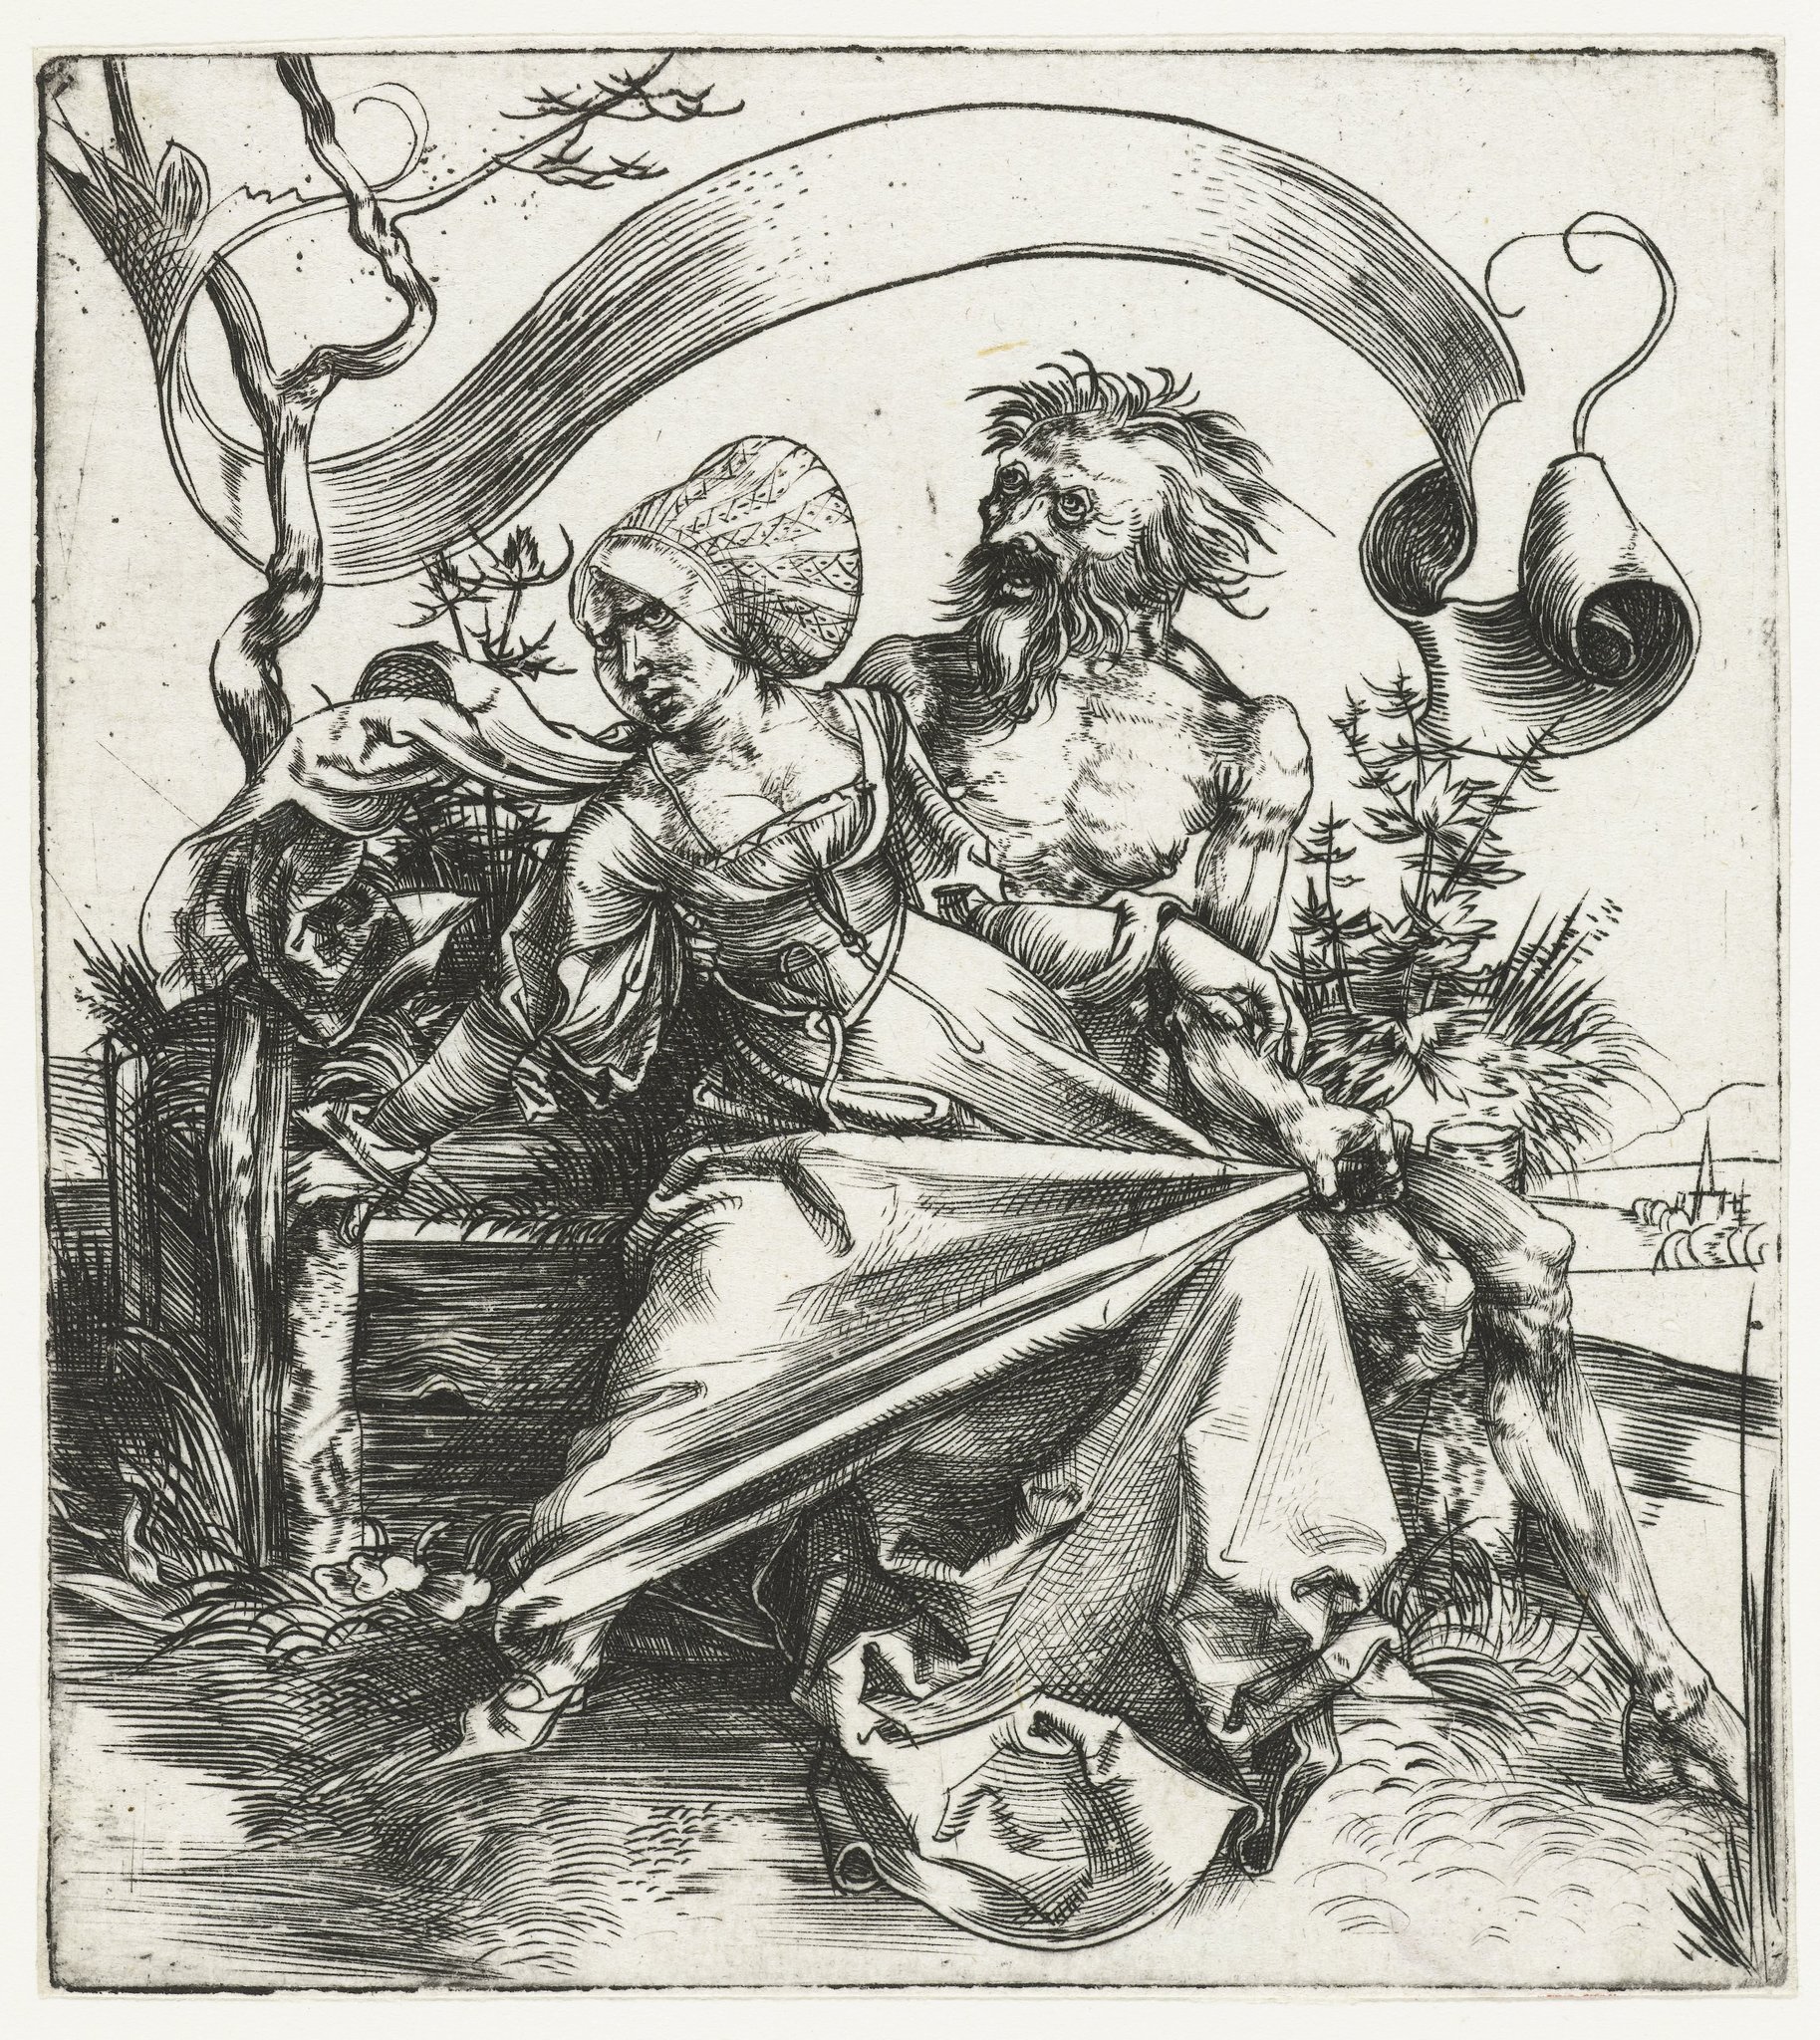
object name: print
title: Jonge vrouw aangevallen door de Dood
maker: albrecht dürer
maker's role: draughtsman, painter, print maker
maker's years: 1471-1528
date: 1493-1497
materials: paper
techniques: engraving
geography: nuremberg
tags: adolescent, young woman, maiden, death as man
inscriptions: collector's mark: Lugt 240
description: Een jonge vrouw zit op een bank naast een blote man met wilde haren. Hij probeert haar te overweldigen, zij weert hem boos af.